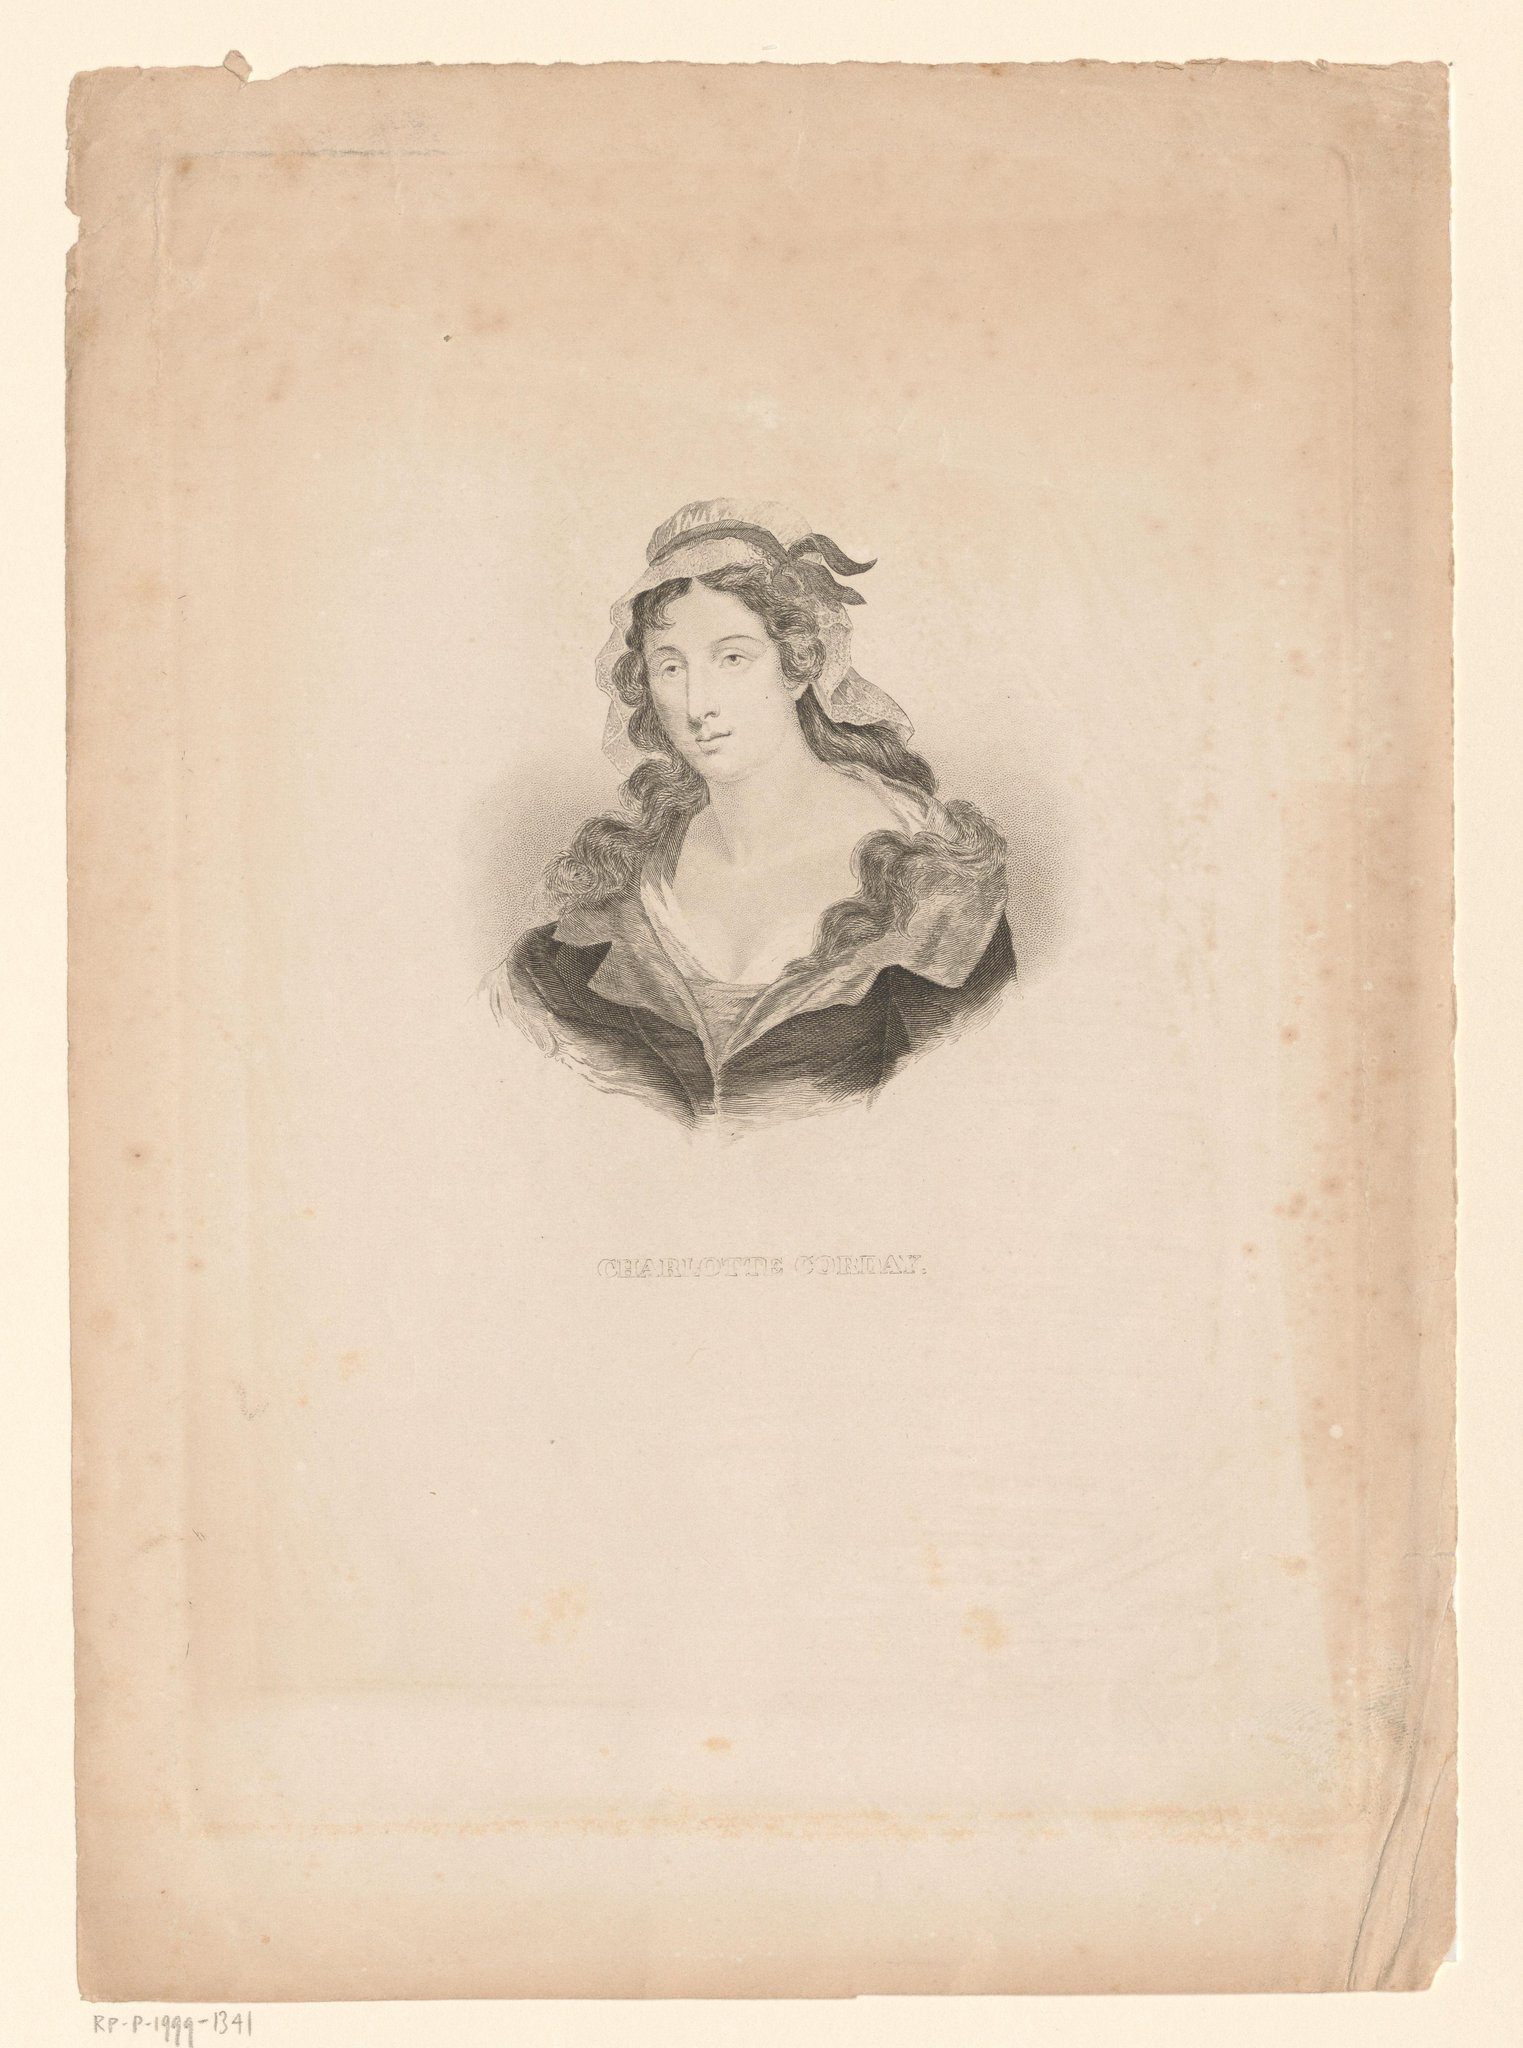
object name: print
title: Portret van Charlotte Corday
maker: Anonymous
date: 1793-1849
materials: paper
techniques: engraving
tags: paris, murder - gg - female, historical persons - bb - woman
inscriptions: collector's mark: Lugt 2760, collector's mark: Lugt 2228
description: Charlotte Corday vermoordde op 13 juli 1793 revolutionair politicus en journalist Jean-Paul Marat in zijn bad.